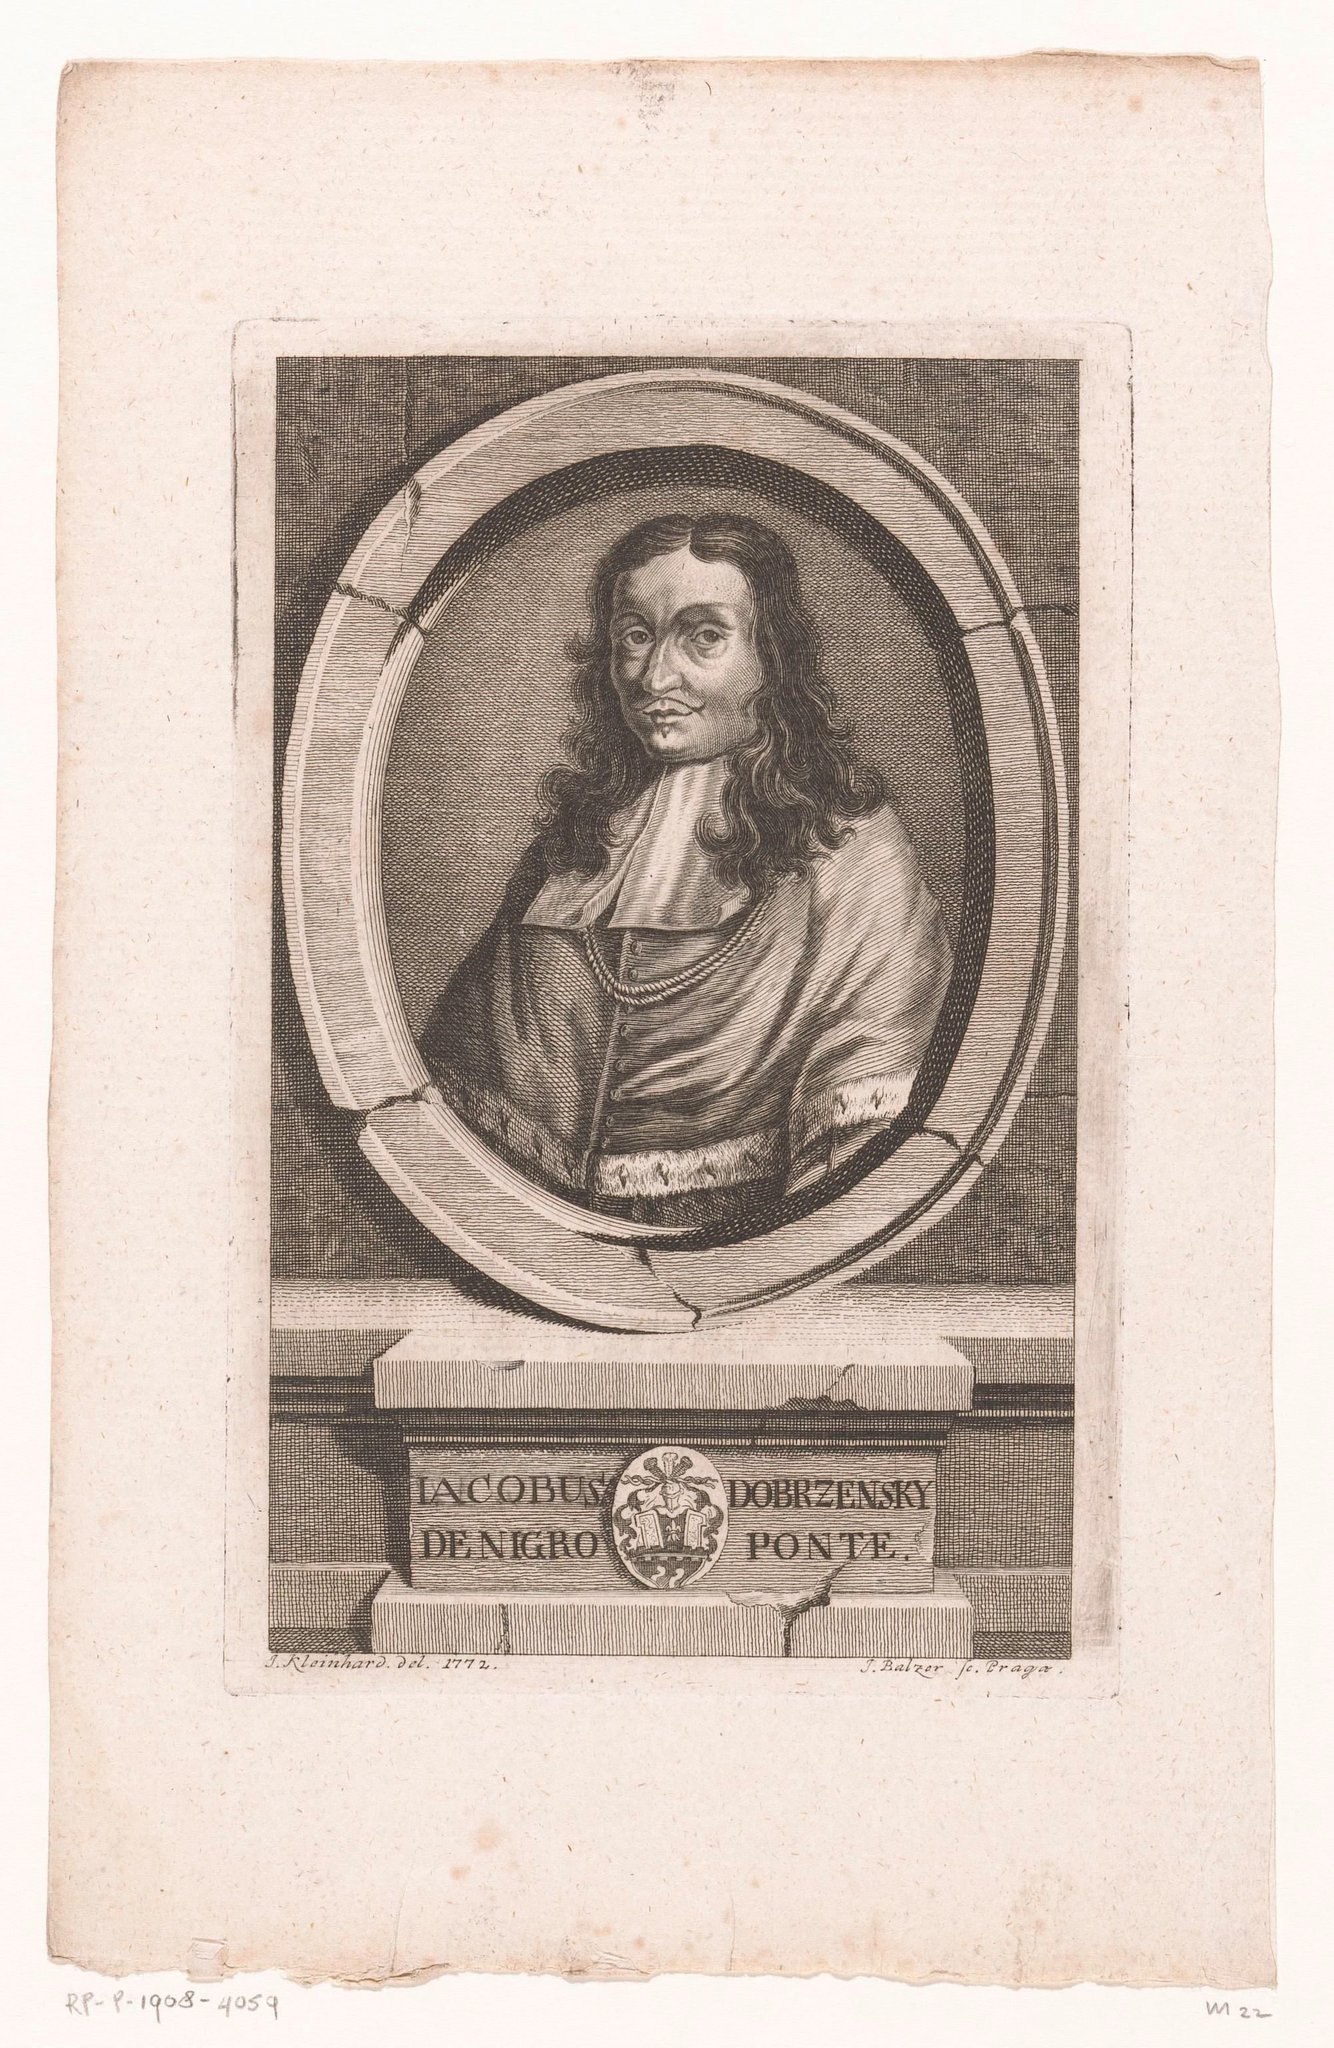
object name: print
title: Iacobus Dobrzensky de Nigro Ponte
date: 1772-1799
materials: paper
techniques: engraving, etching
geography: prague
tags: historical persons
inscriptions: collector's mark: Lugt 2228